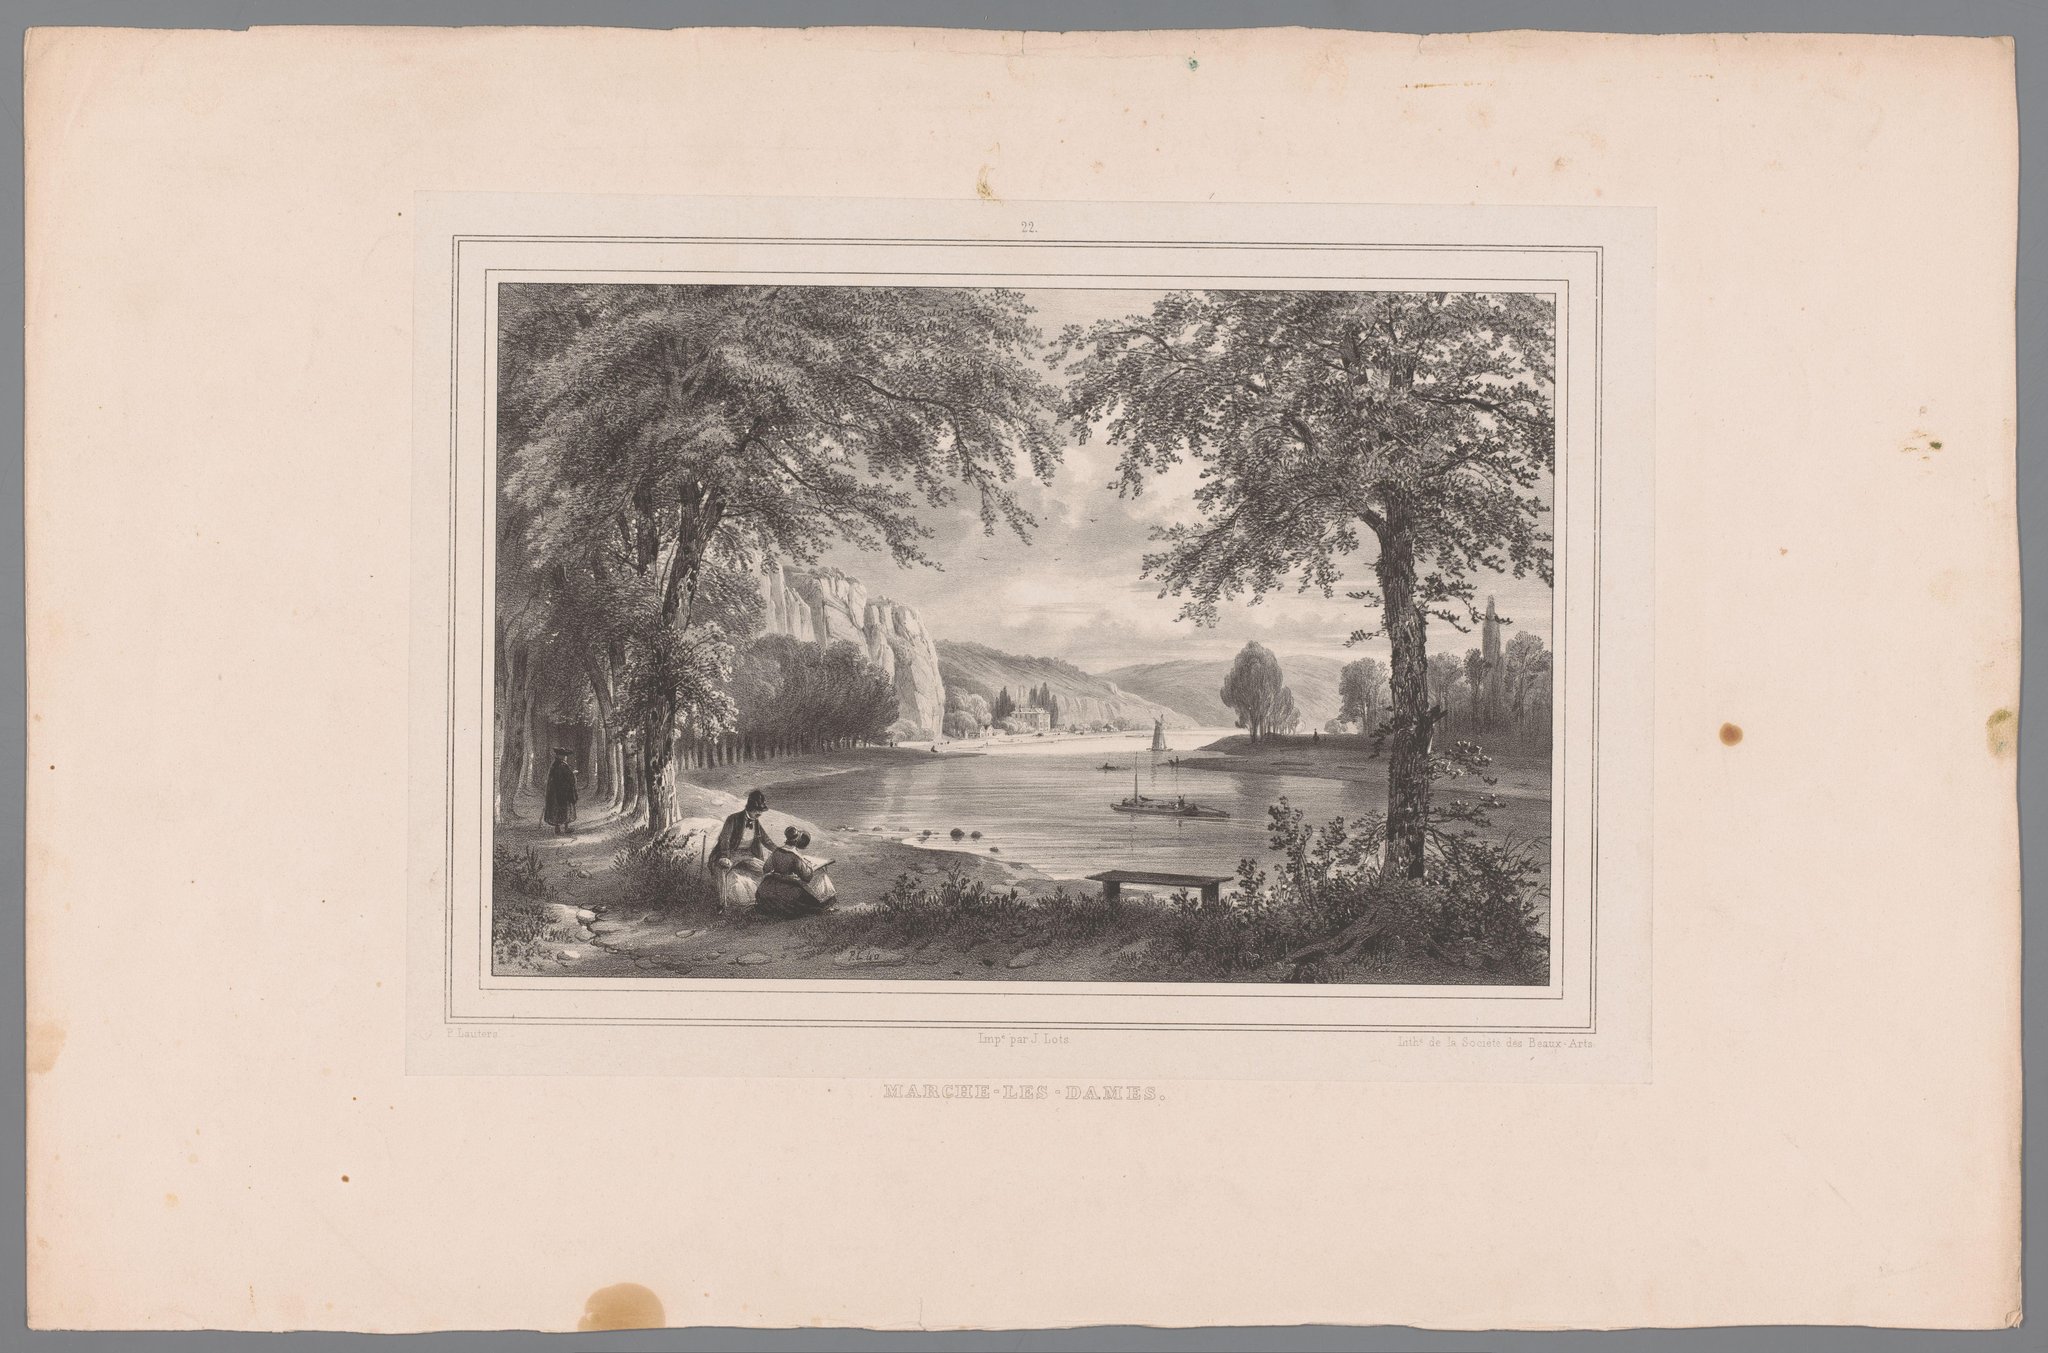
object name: print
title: Marche-les-Dames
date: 1839-1841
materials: paper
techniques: lithograph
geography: brussels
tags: river, draughtsman at work - cc - out of doors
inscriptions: collector's mark: Lugt 2228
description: Prent verschenen in: Van Hasselt, André. Voyage aux bords de la Meuse. Brussel: Société des Beaux-Arts, 1839-1841. Deze publicatie bevat 36 litho's.